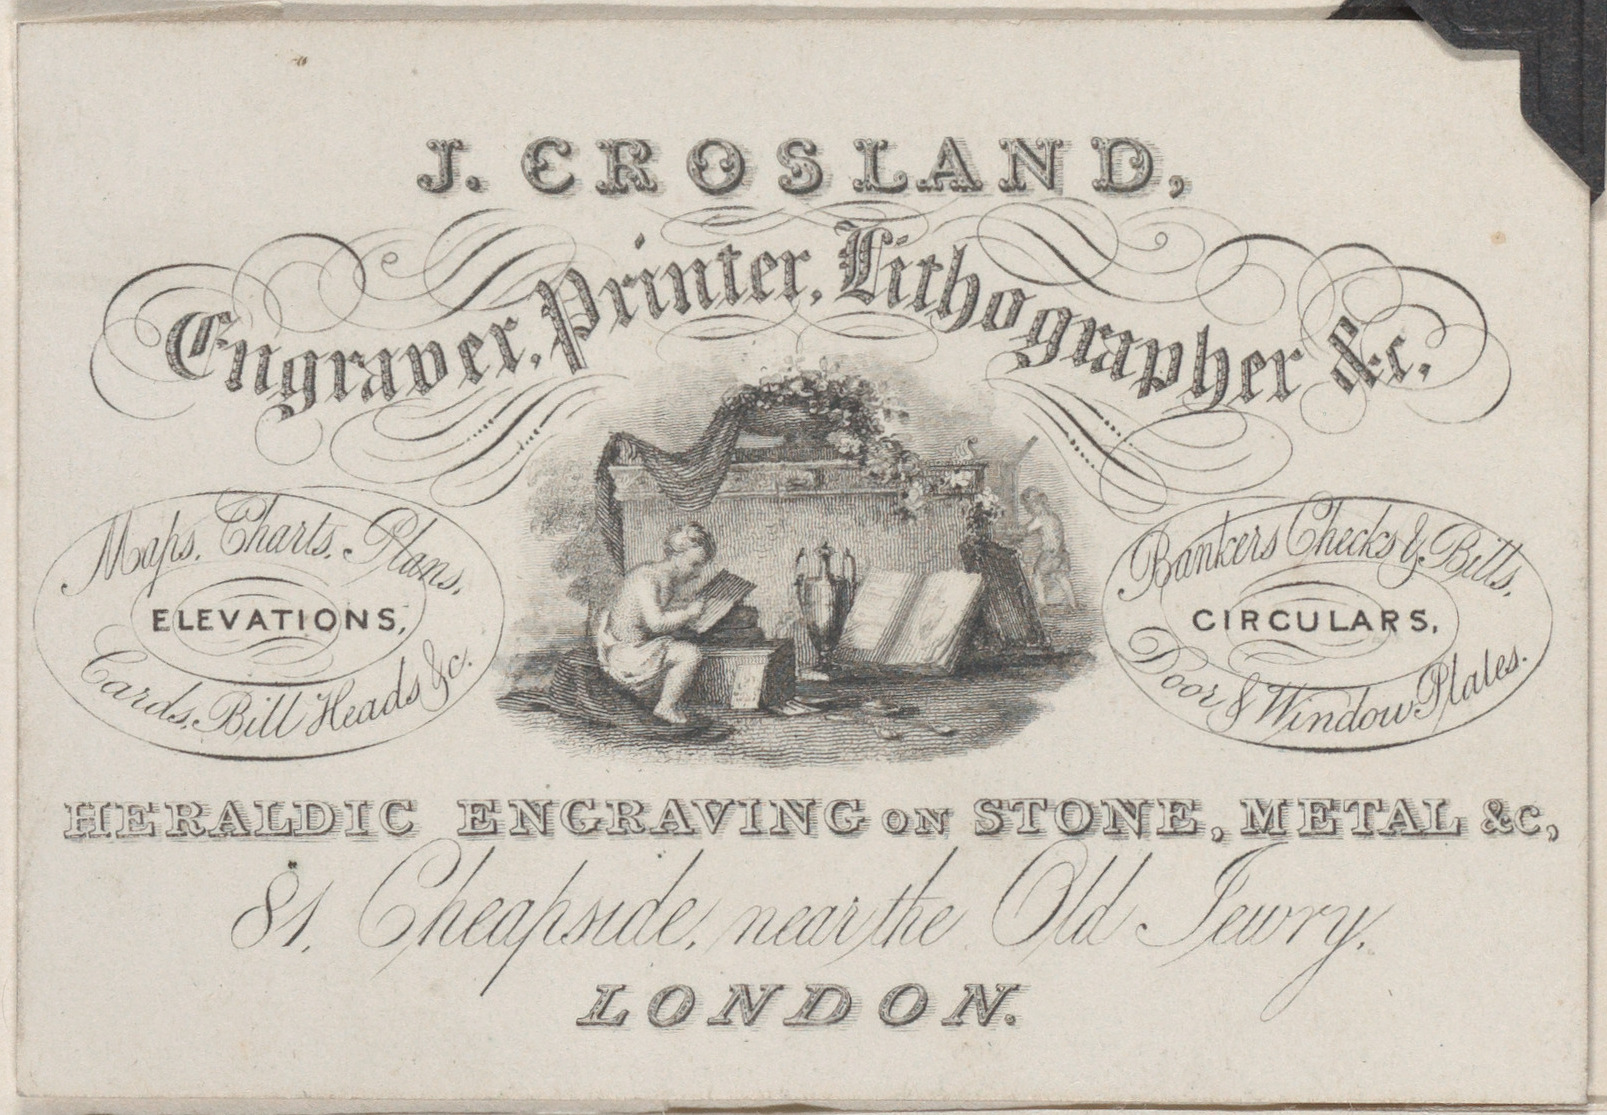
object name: print, trade card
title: Trade Card for J. Crosland, Engraver, Printer, and Lithographer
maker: anonymous, british, 19th century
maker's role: artist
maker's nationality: british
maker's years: 1800-1900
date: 1801-1900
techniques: engraving